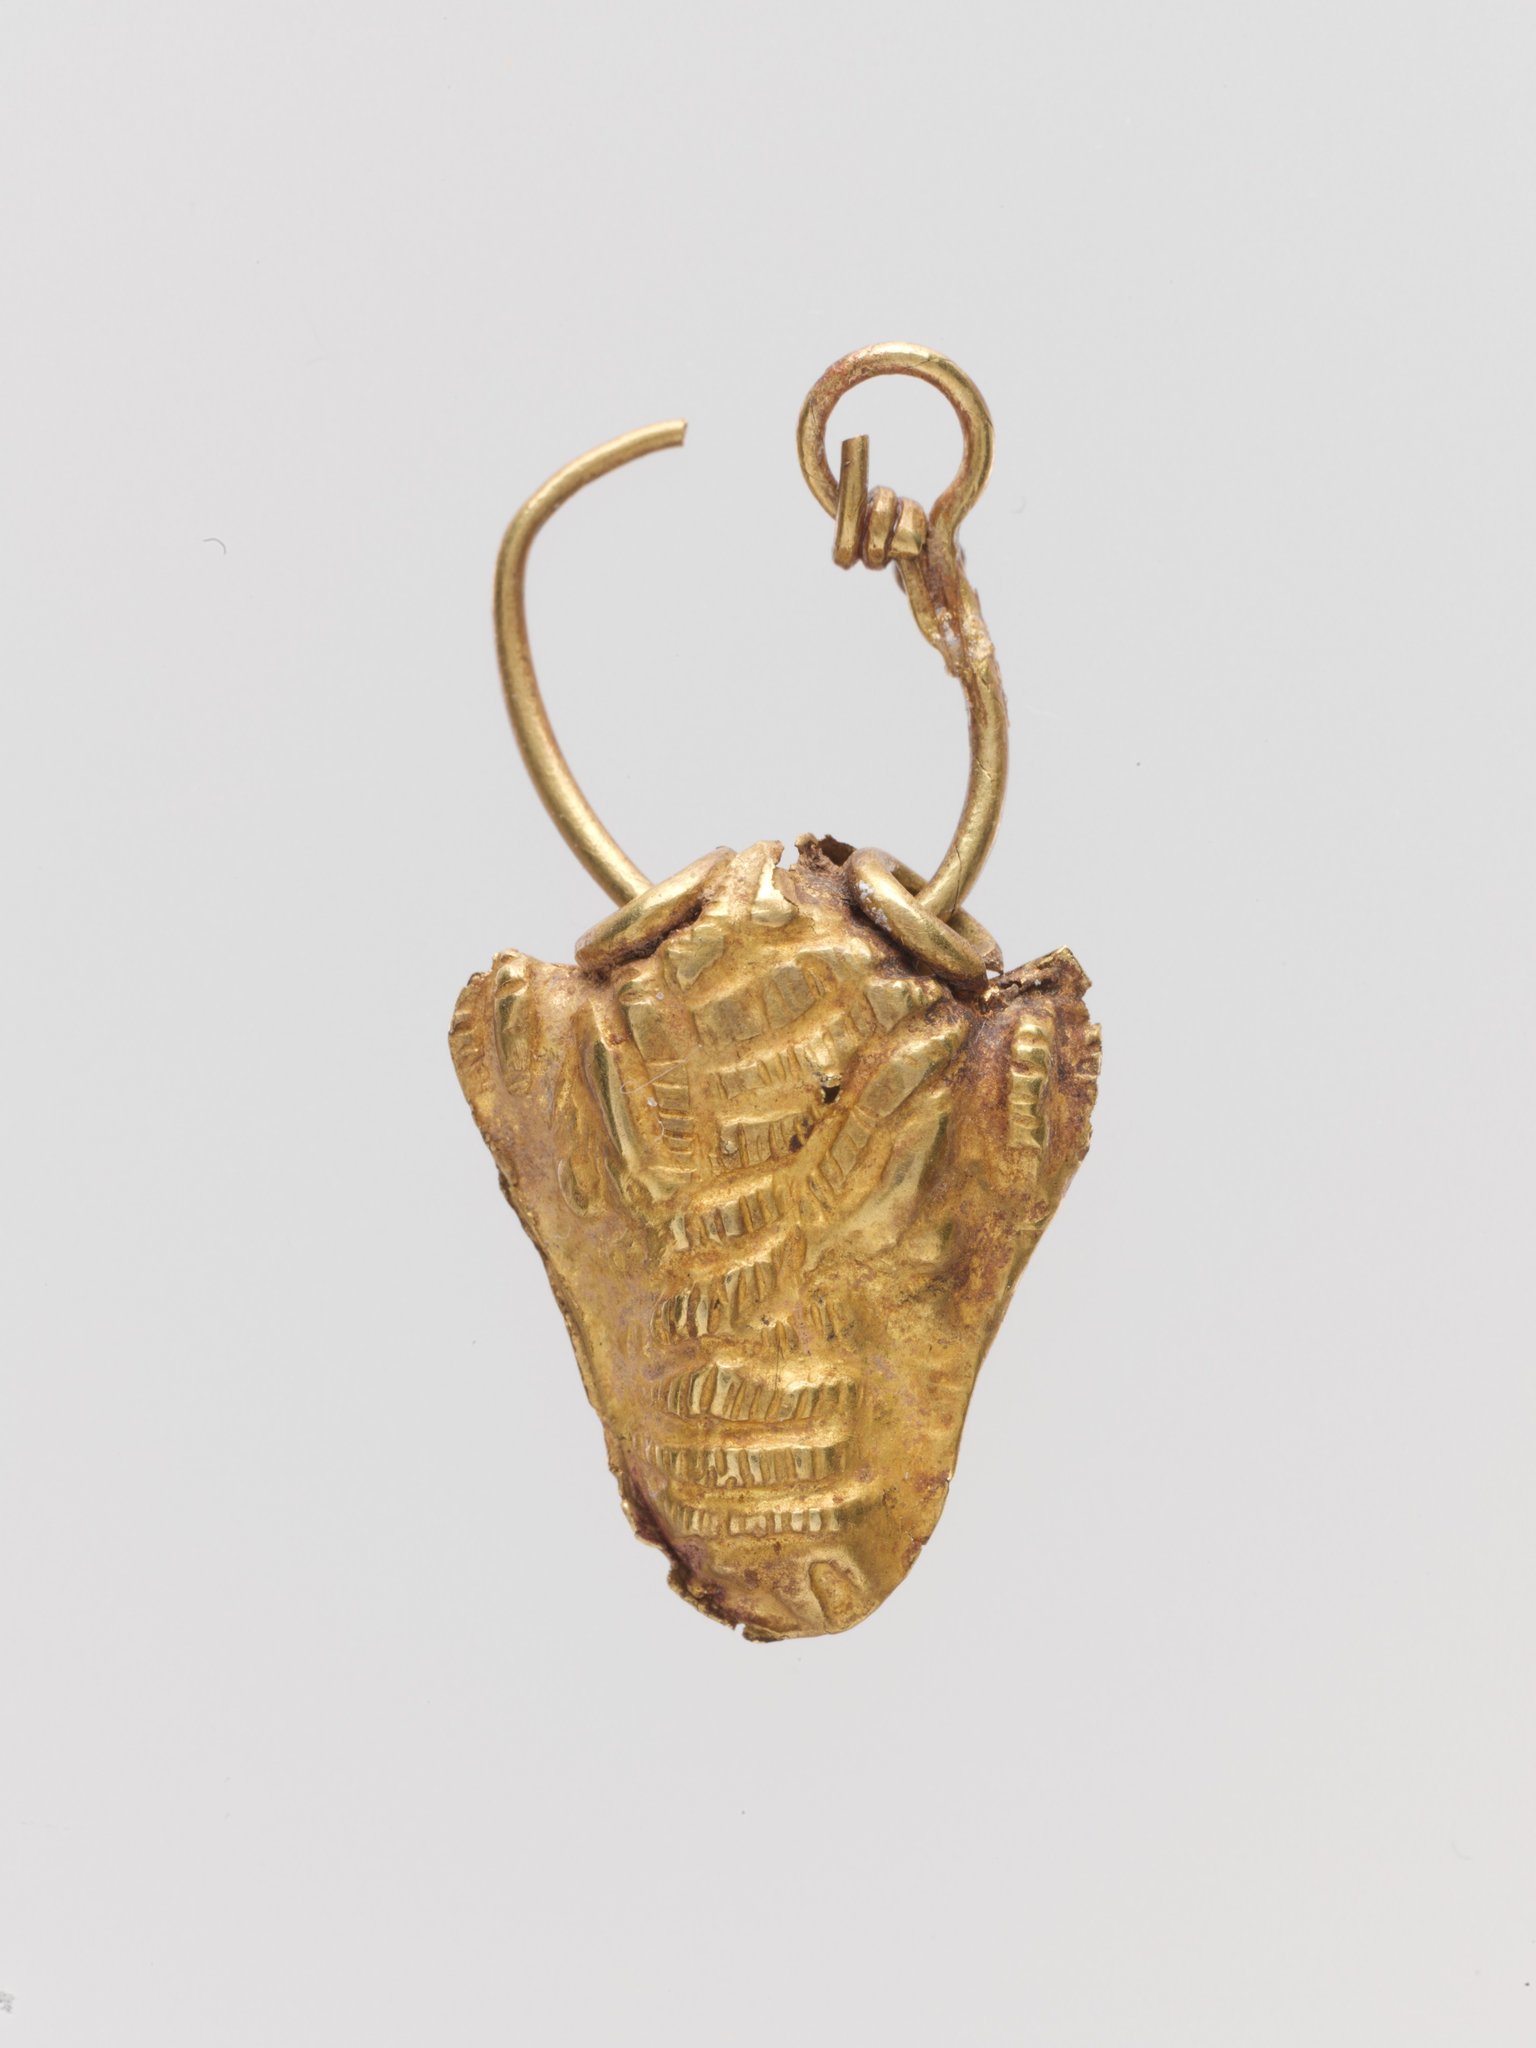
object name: earring with head of bull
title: Gold pendant in the form of a bull's head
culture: cypriot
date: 1400-1050 BCE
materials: gold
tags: bulls